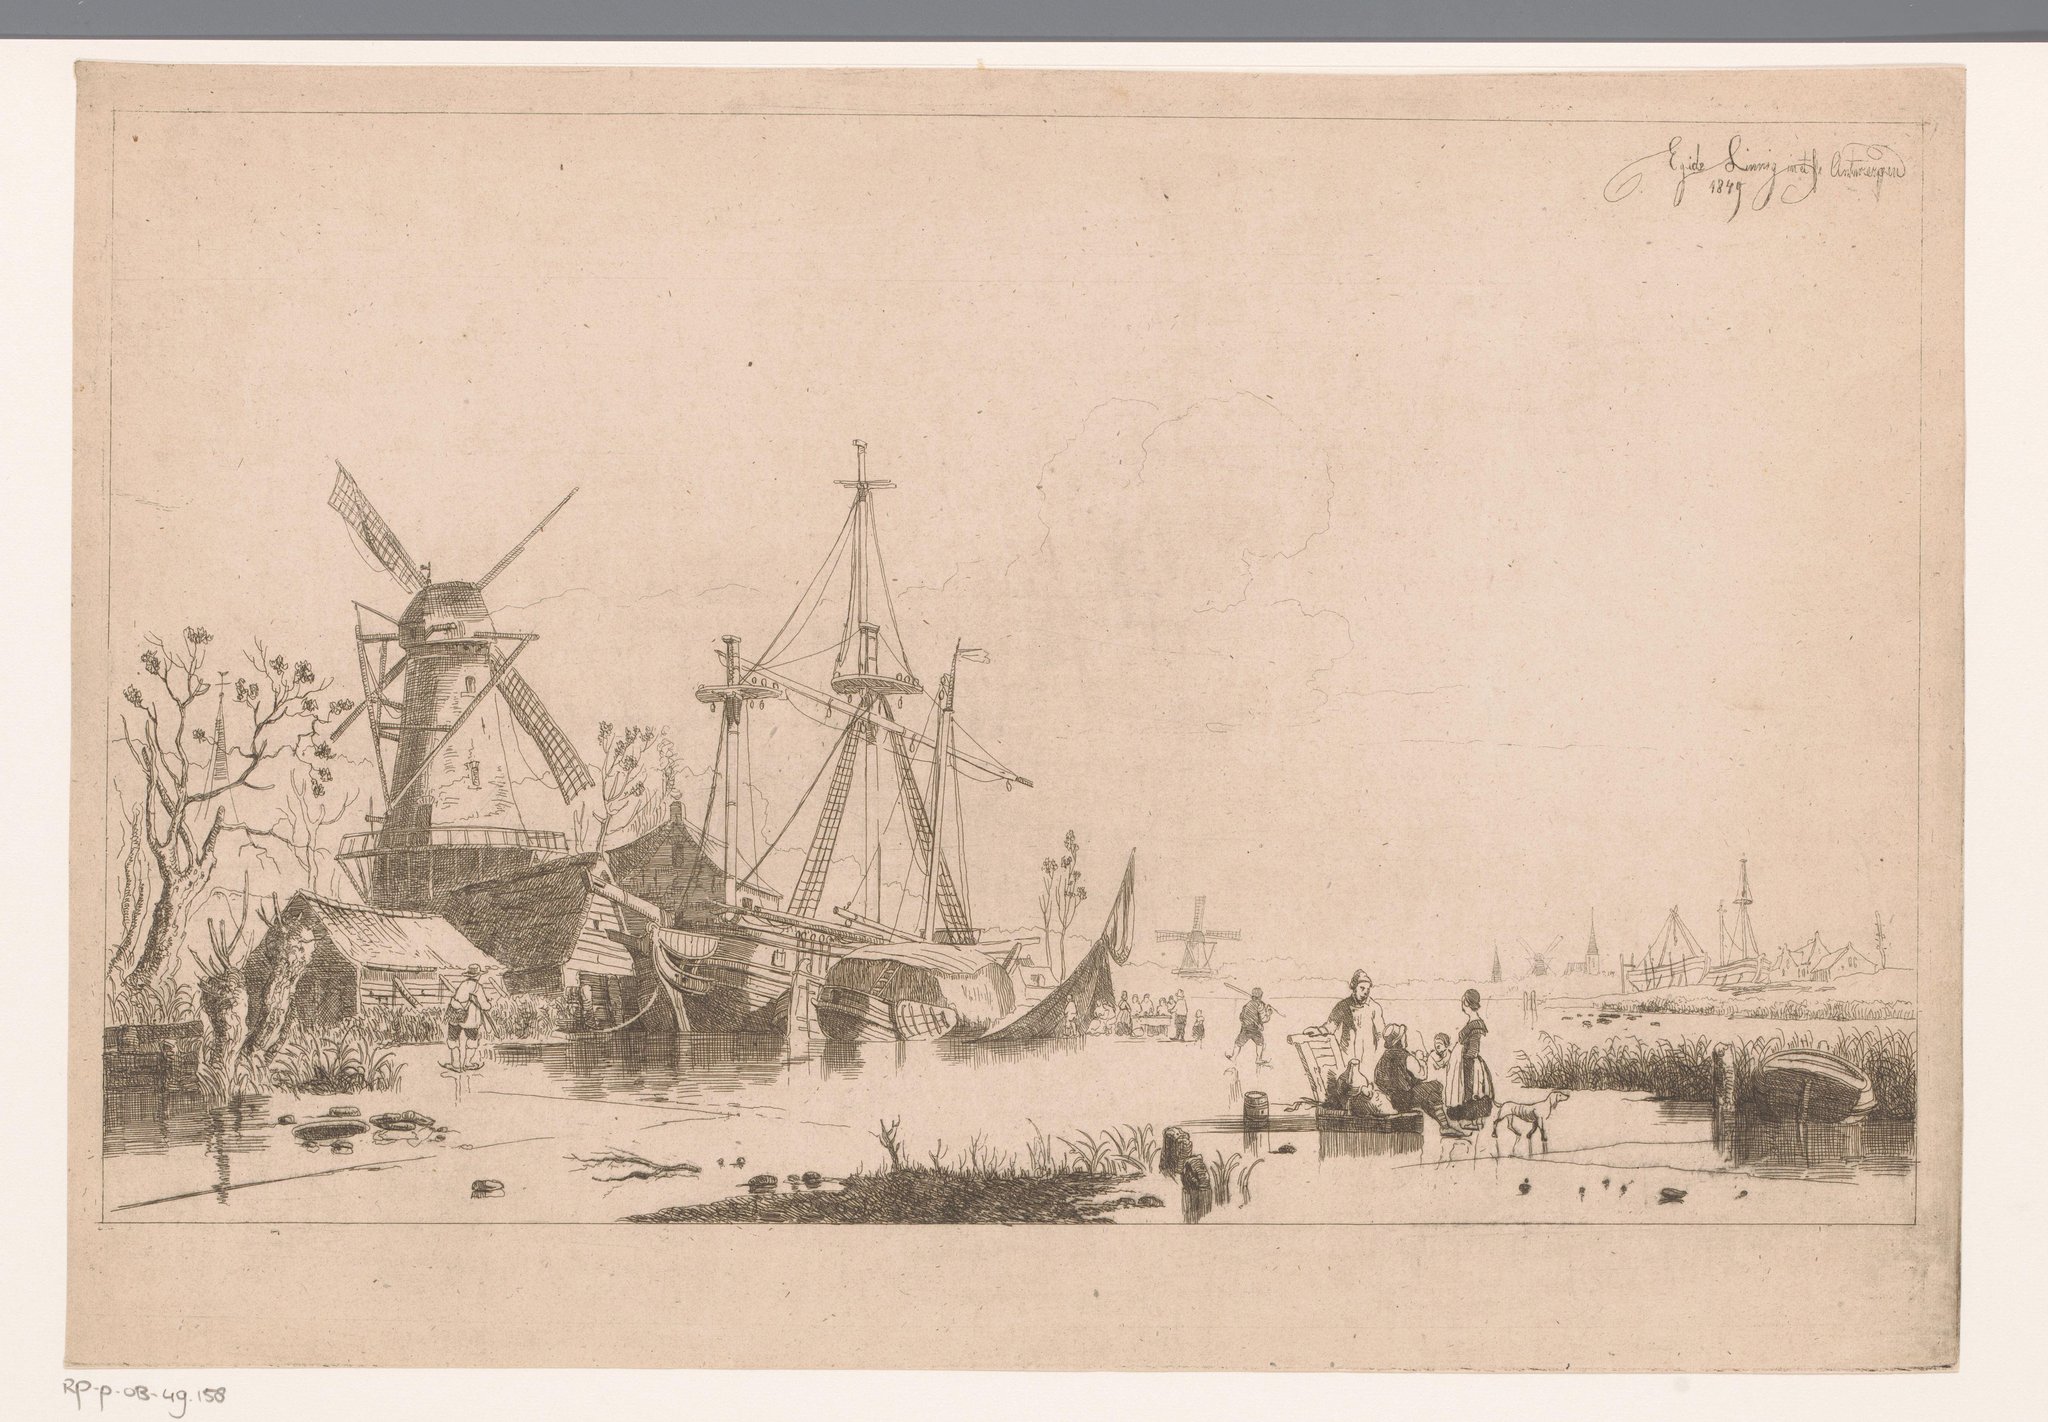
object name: print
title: Bij een molen langs een dichtgevroren kanaal in Nederland liggen boten aangemeerd naast een tent op het ijs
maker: egidius linnig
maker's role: draughtsman, print maker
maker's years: 1821-1860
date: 1849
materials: paper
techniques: etching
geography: antwerp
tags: skates (winter sports), dry-dock, floating-dock, ice ~ state of water, windmill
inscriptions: collector's mark: Lugt 2228